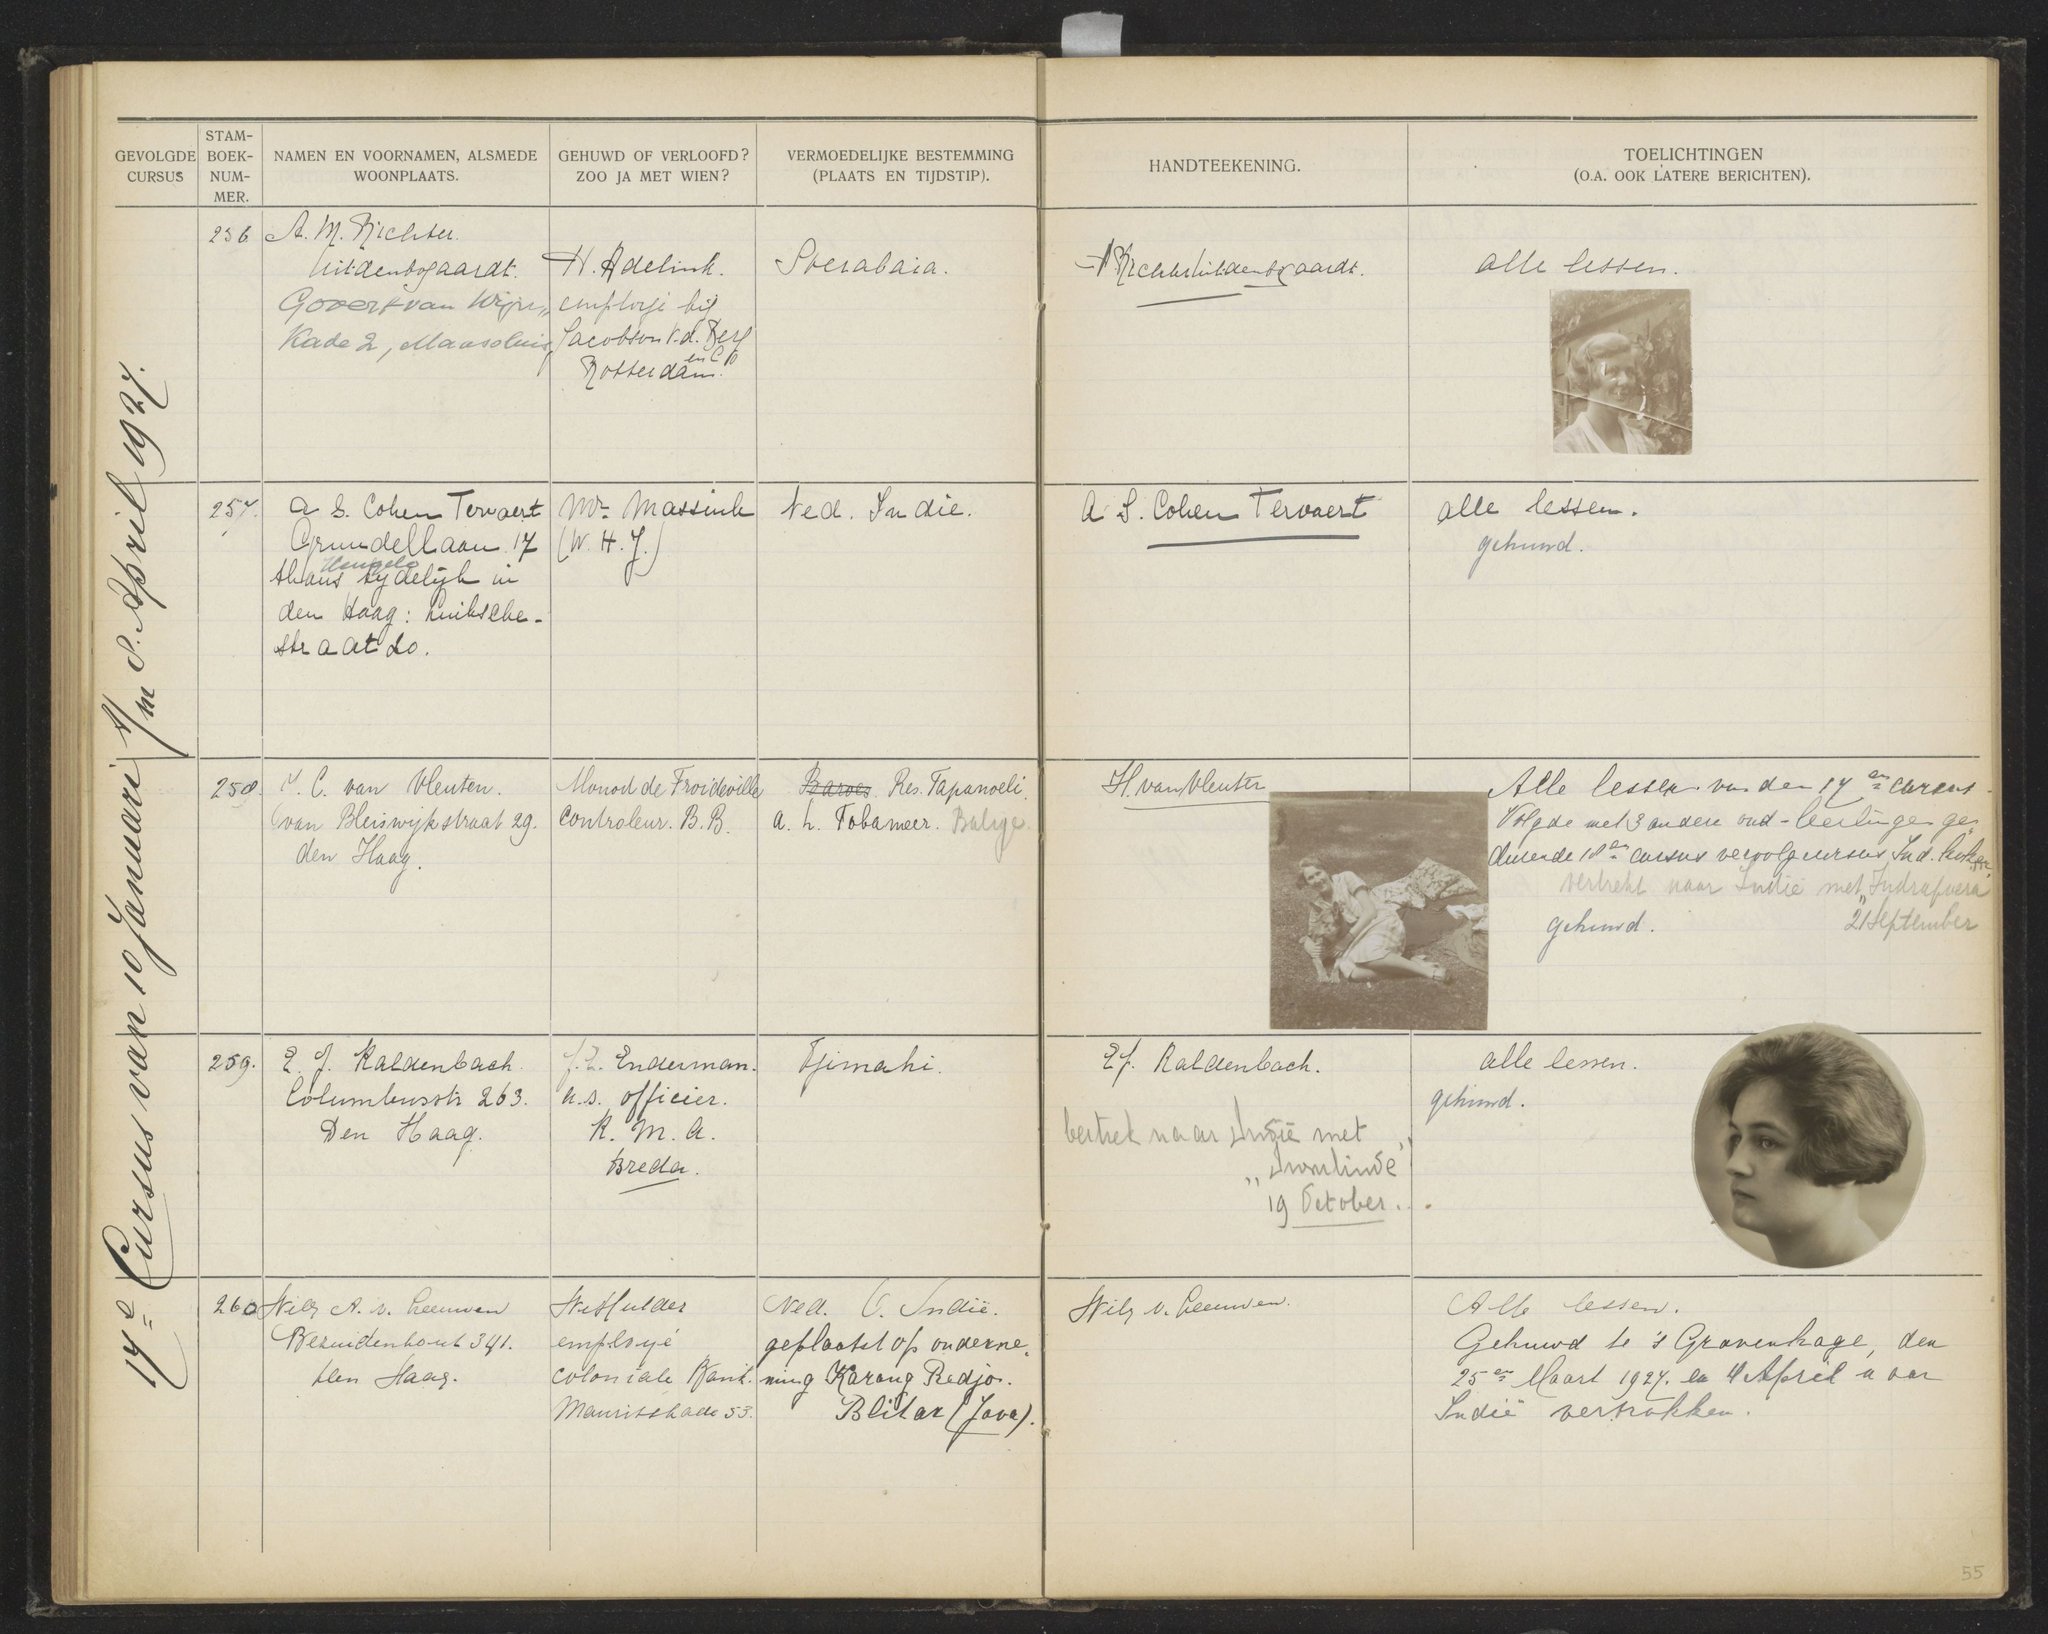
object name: album leaf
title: Blad 55 uit Stamboek van de leerlingen der Koloniale School voor Meisjes en Vrouwen te 's-Gravenhage deel I (1921-1929)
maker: Anonymous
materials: paper, photographic support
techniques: photography, printing, writing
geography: the hague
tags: further education (+ pupil), further education, the hague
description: Twee pagina's met gegevens van de deelnemers aan de 17e driemaandelijkse cursus van 10 januari tot en met 8 april 1927, stamboeknummers 256 tot en met 260. Onderdeel van Stamboek van de leerlingen der Koloniale School voor Meisjes en Vrouwen te 's-Gravenhage deel I (1921-1929).